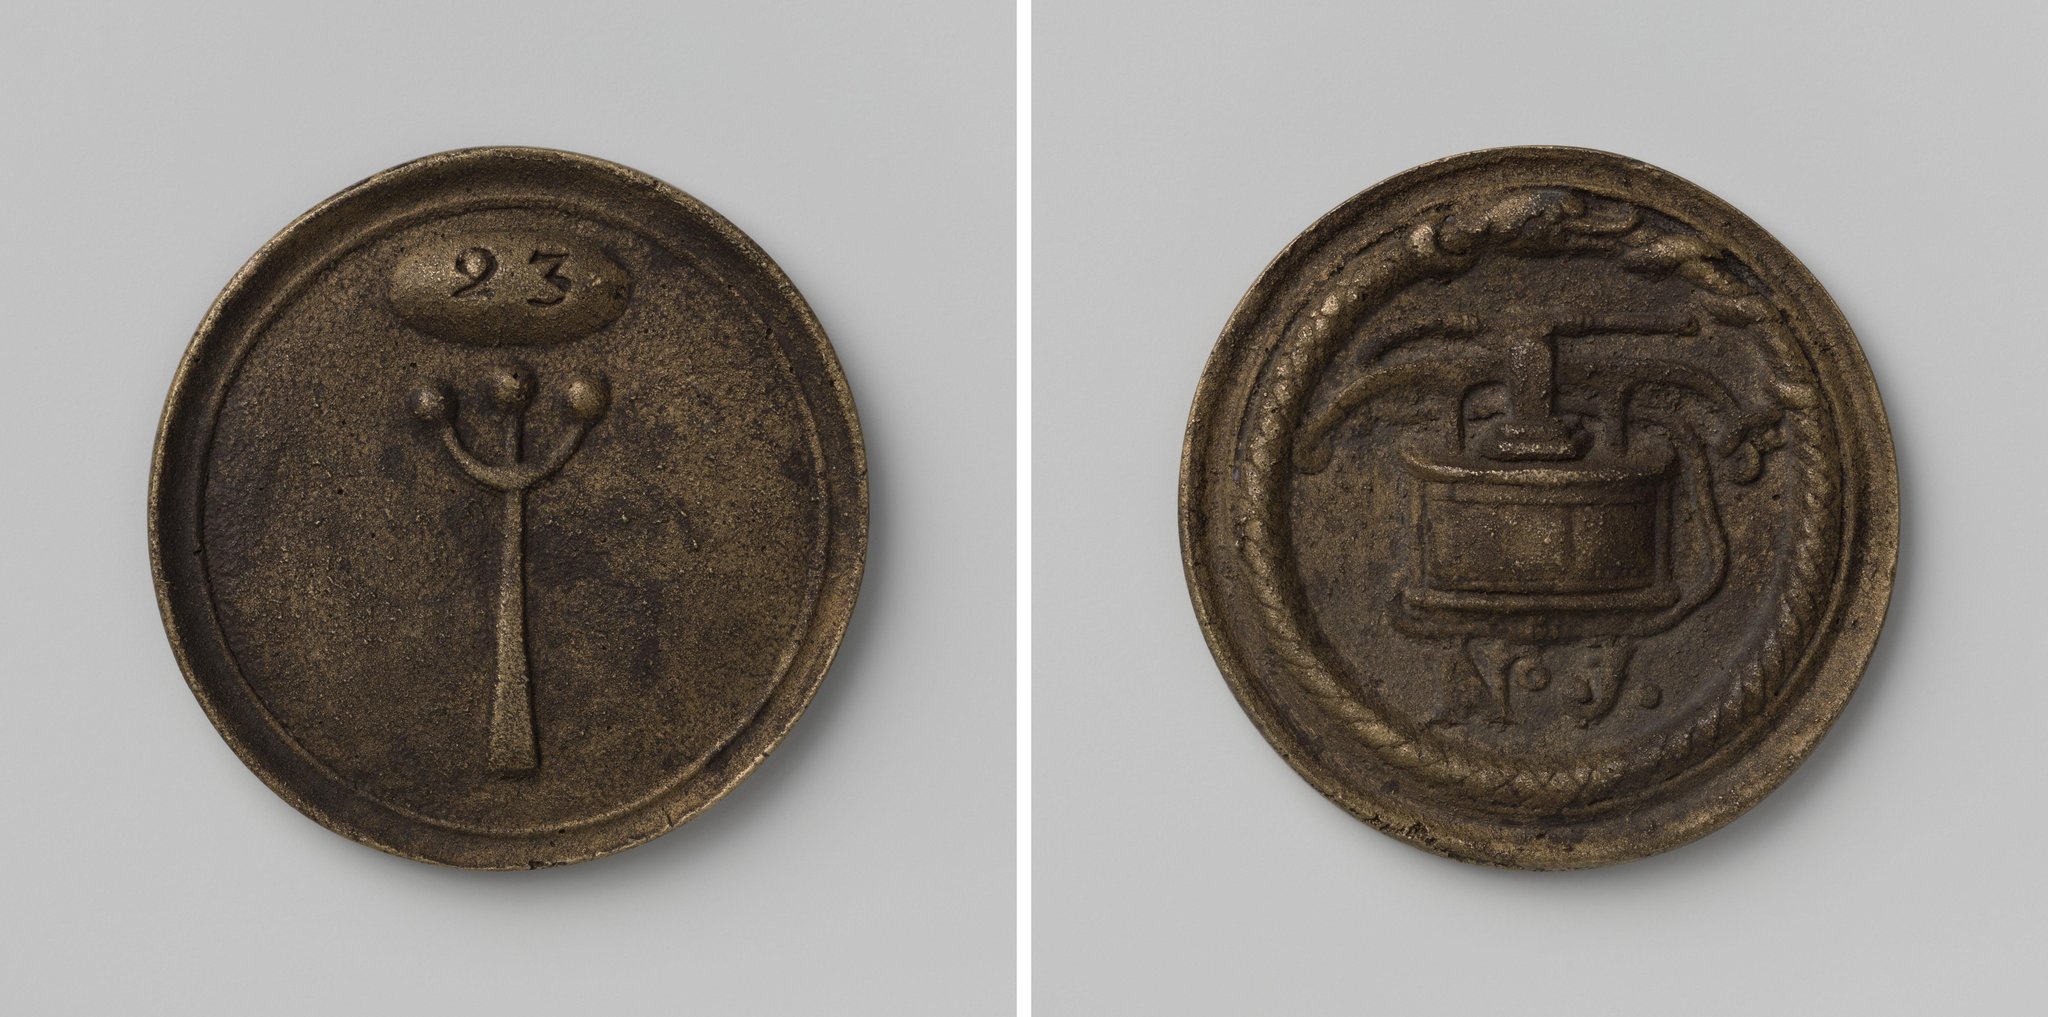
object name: fire engine medal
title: Oostzaan, brandspuitpenning van spuit 1 met no. 23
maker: Anonymous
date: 1680-1800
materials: brass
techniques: casting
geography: oostzaan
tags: oostzaan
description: Messing penning. Voorzijde: drietandige hooivork met daarop drie kaarsjes onder een compartiment met no. 23. Keerzijde: brandspuit boven opschrift No. 1 binnen slangerond